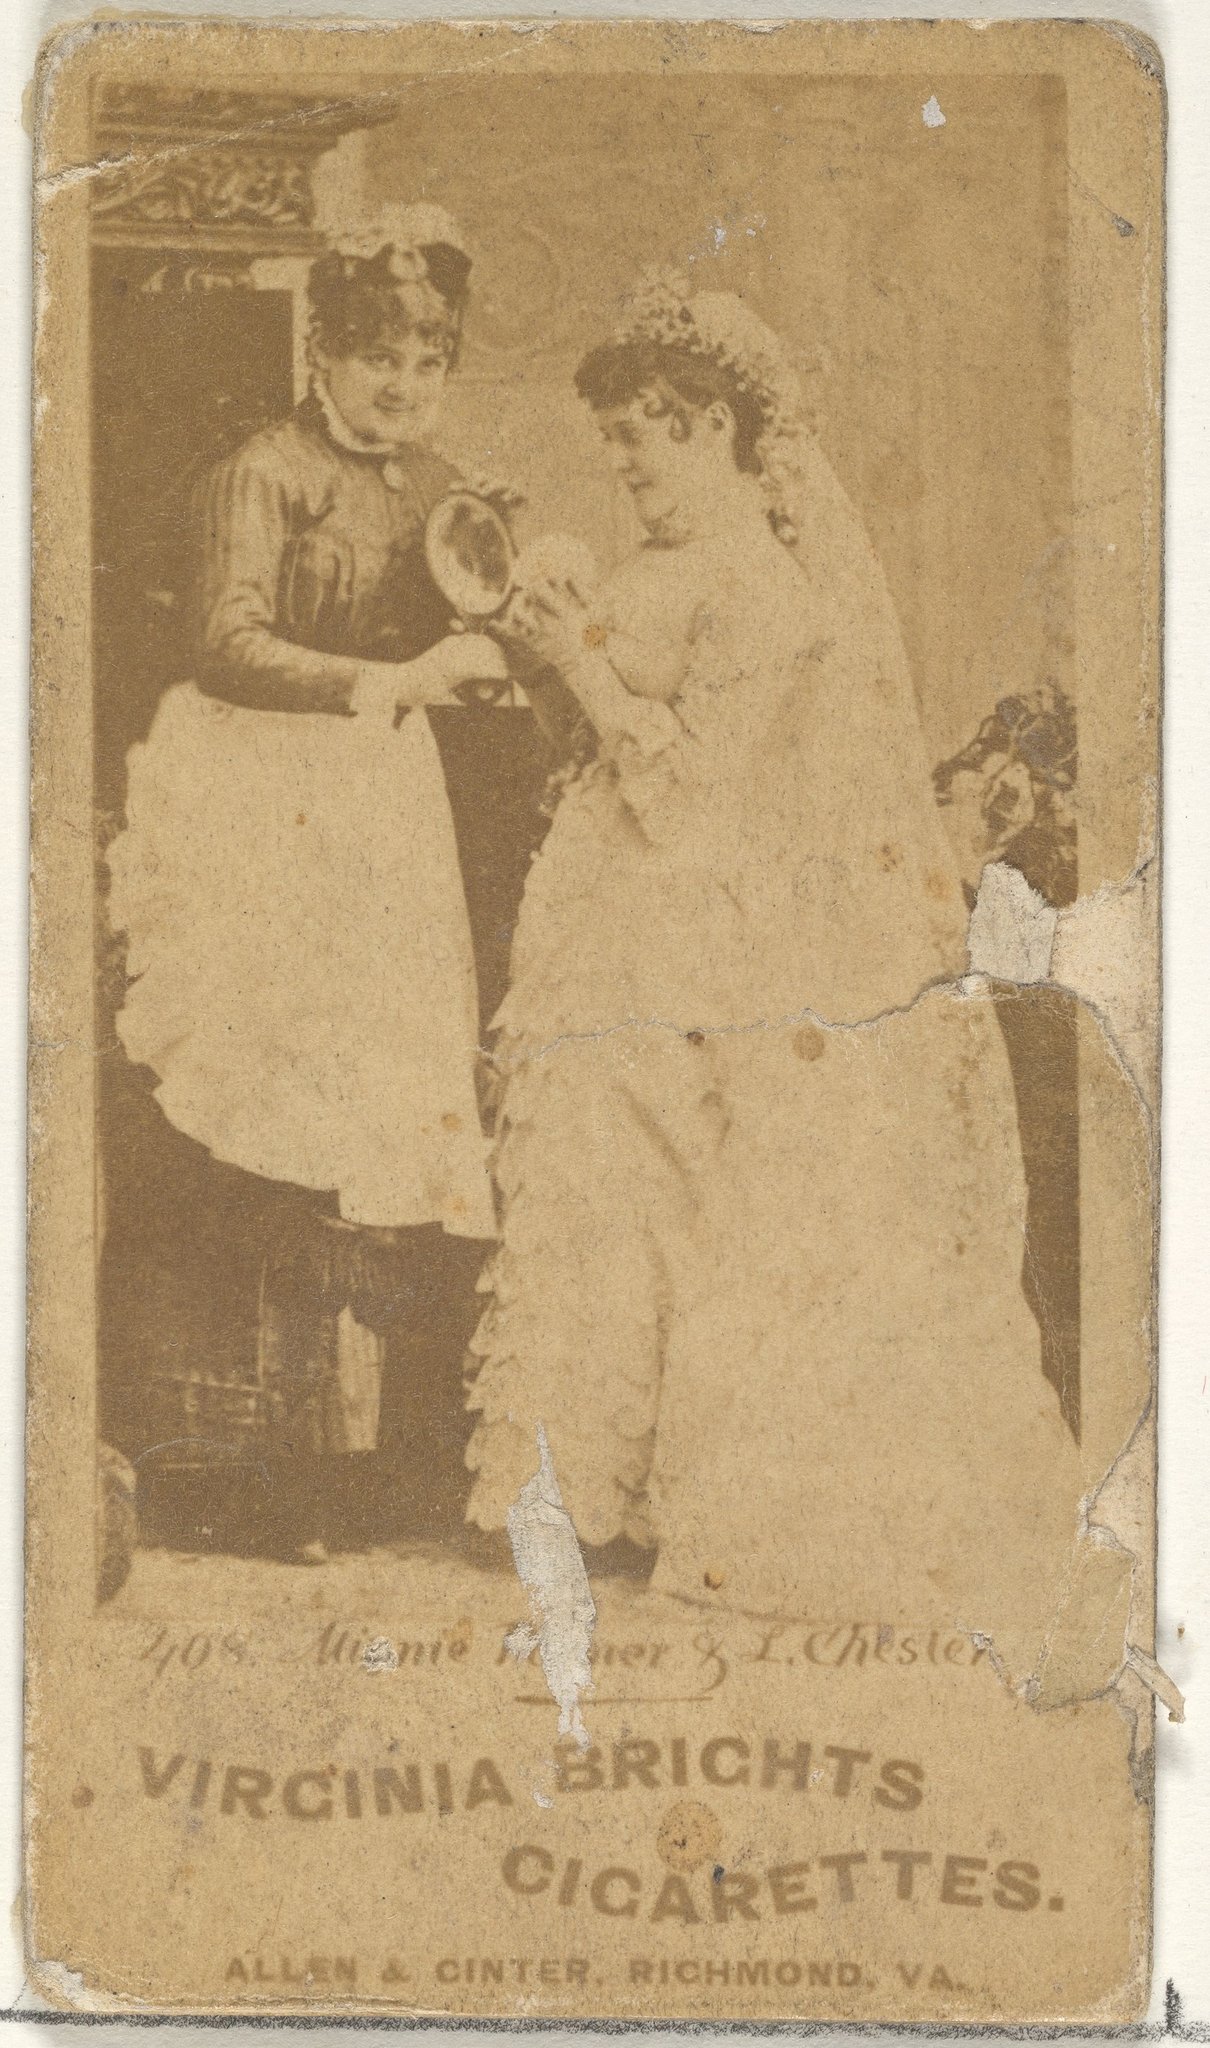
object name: photograph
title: Card 408, Minnie Palmer and L. Chester, from the Actors and Actresses series (N45, Type 1) for Virginia Brights Cigarettes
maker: allen & ginter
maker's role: publisher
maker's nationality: american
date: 1888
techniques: albumen silver print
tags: portraits,women,actresses